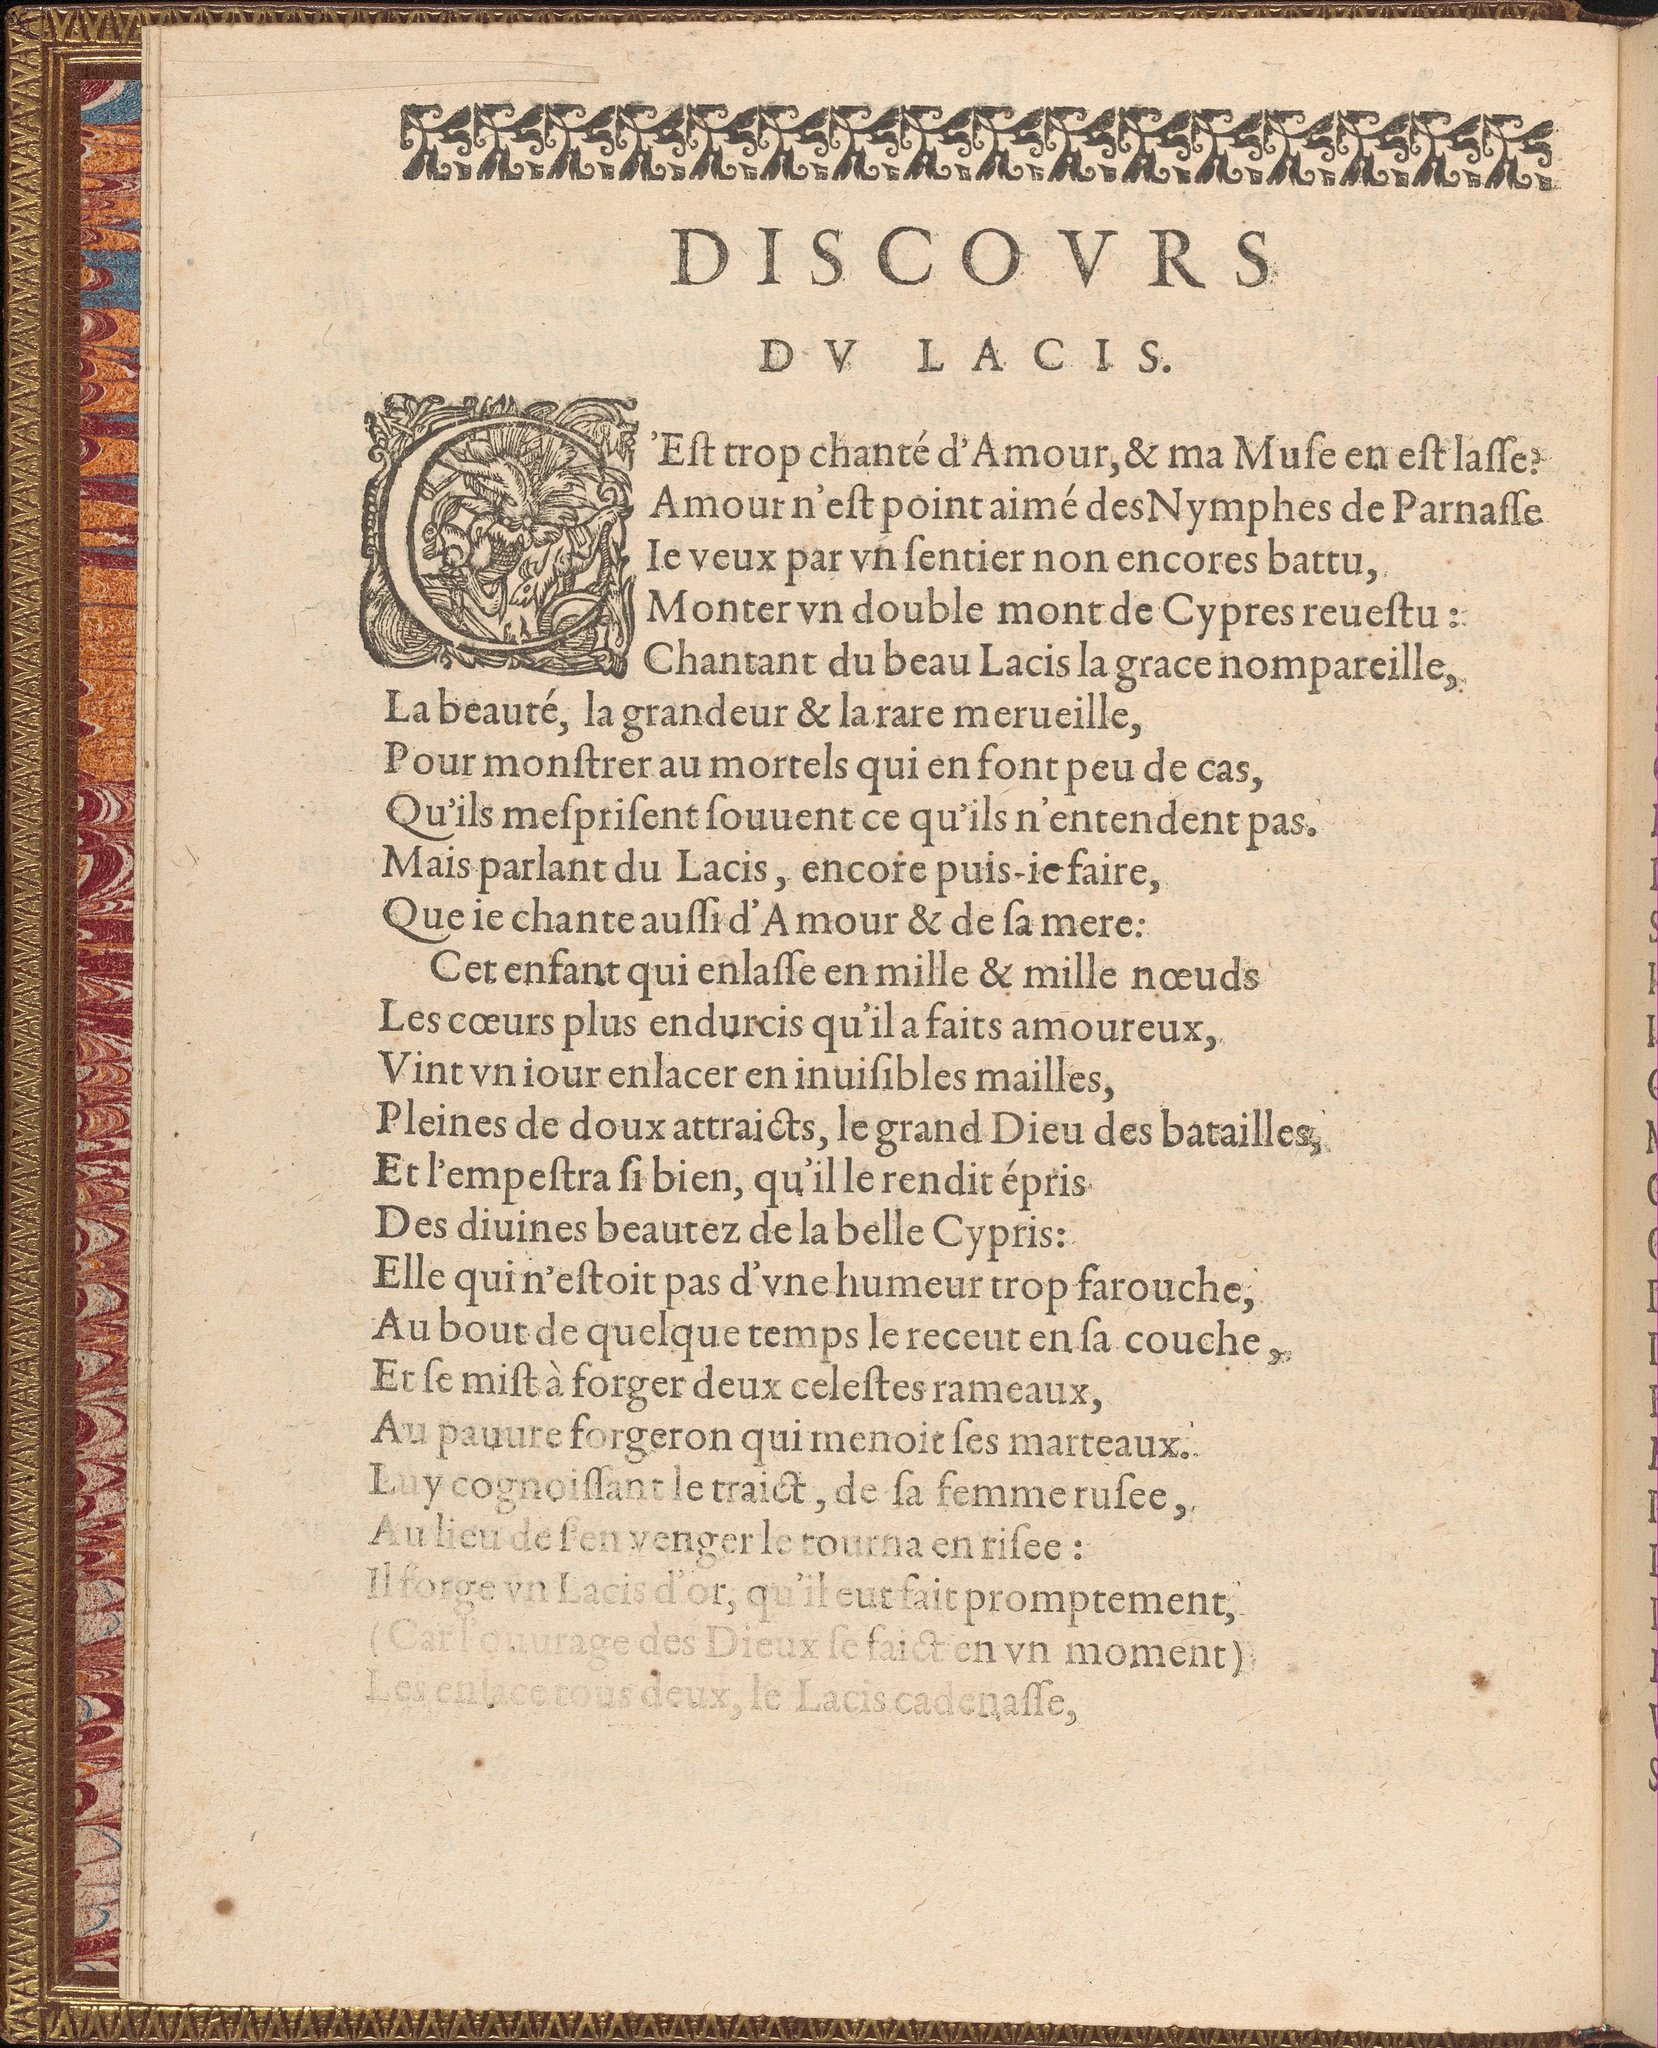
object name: book print ornament architecture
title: La Pratique de l'Aiguille, page 2 (verso)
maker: matthias mignerak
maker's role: author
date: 1605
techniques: woodcut